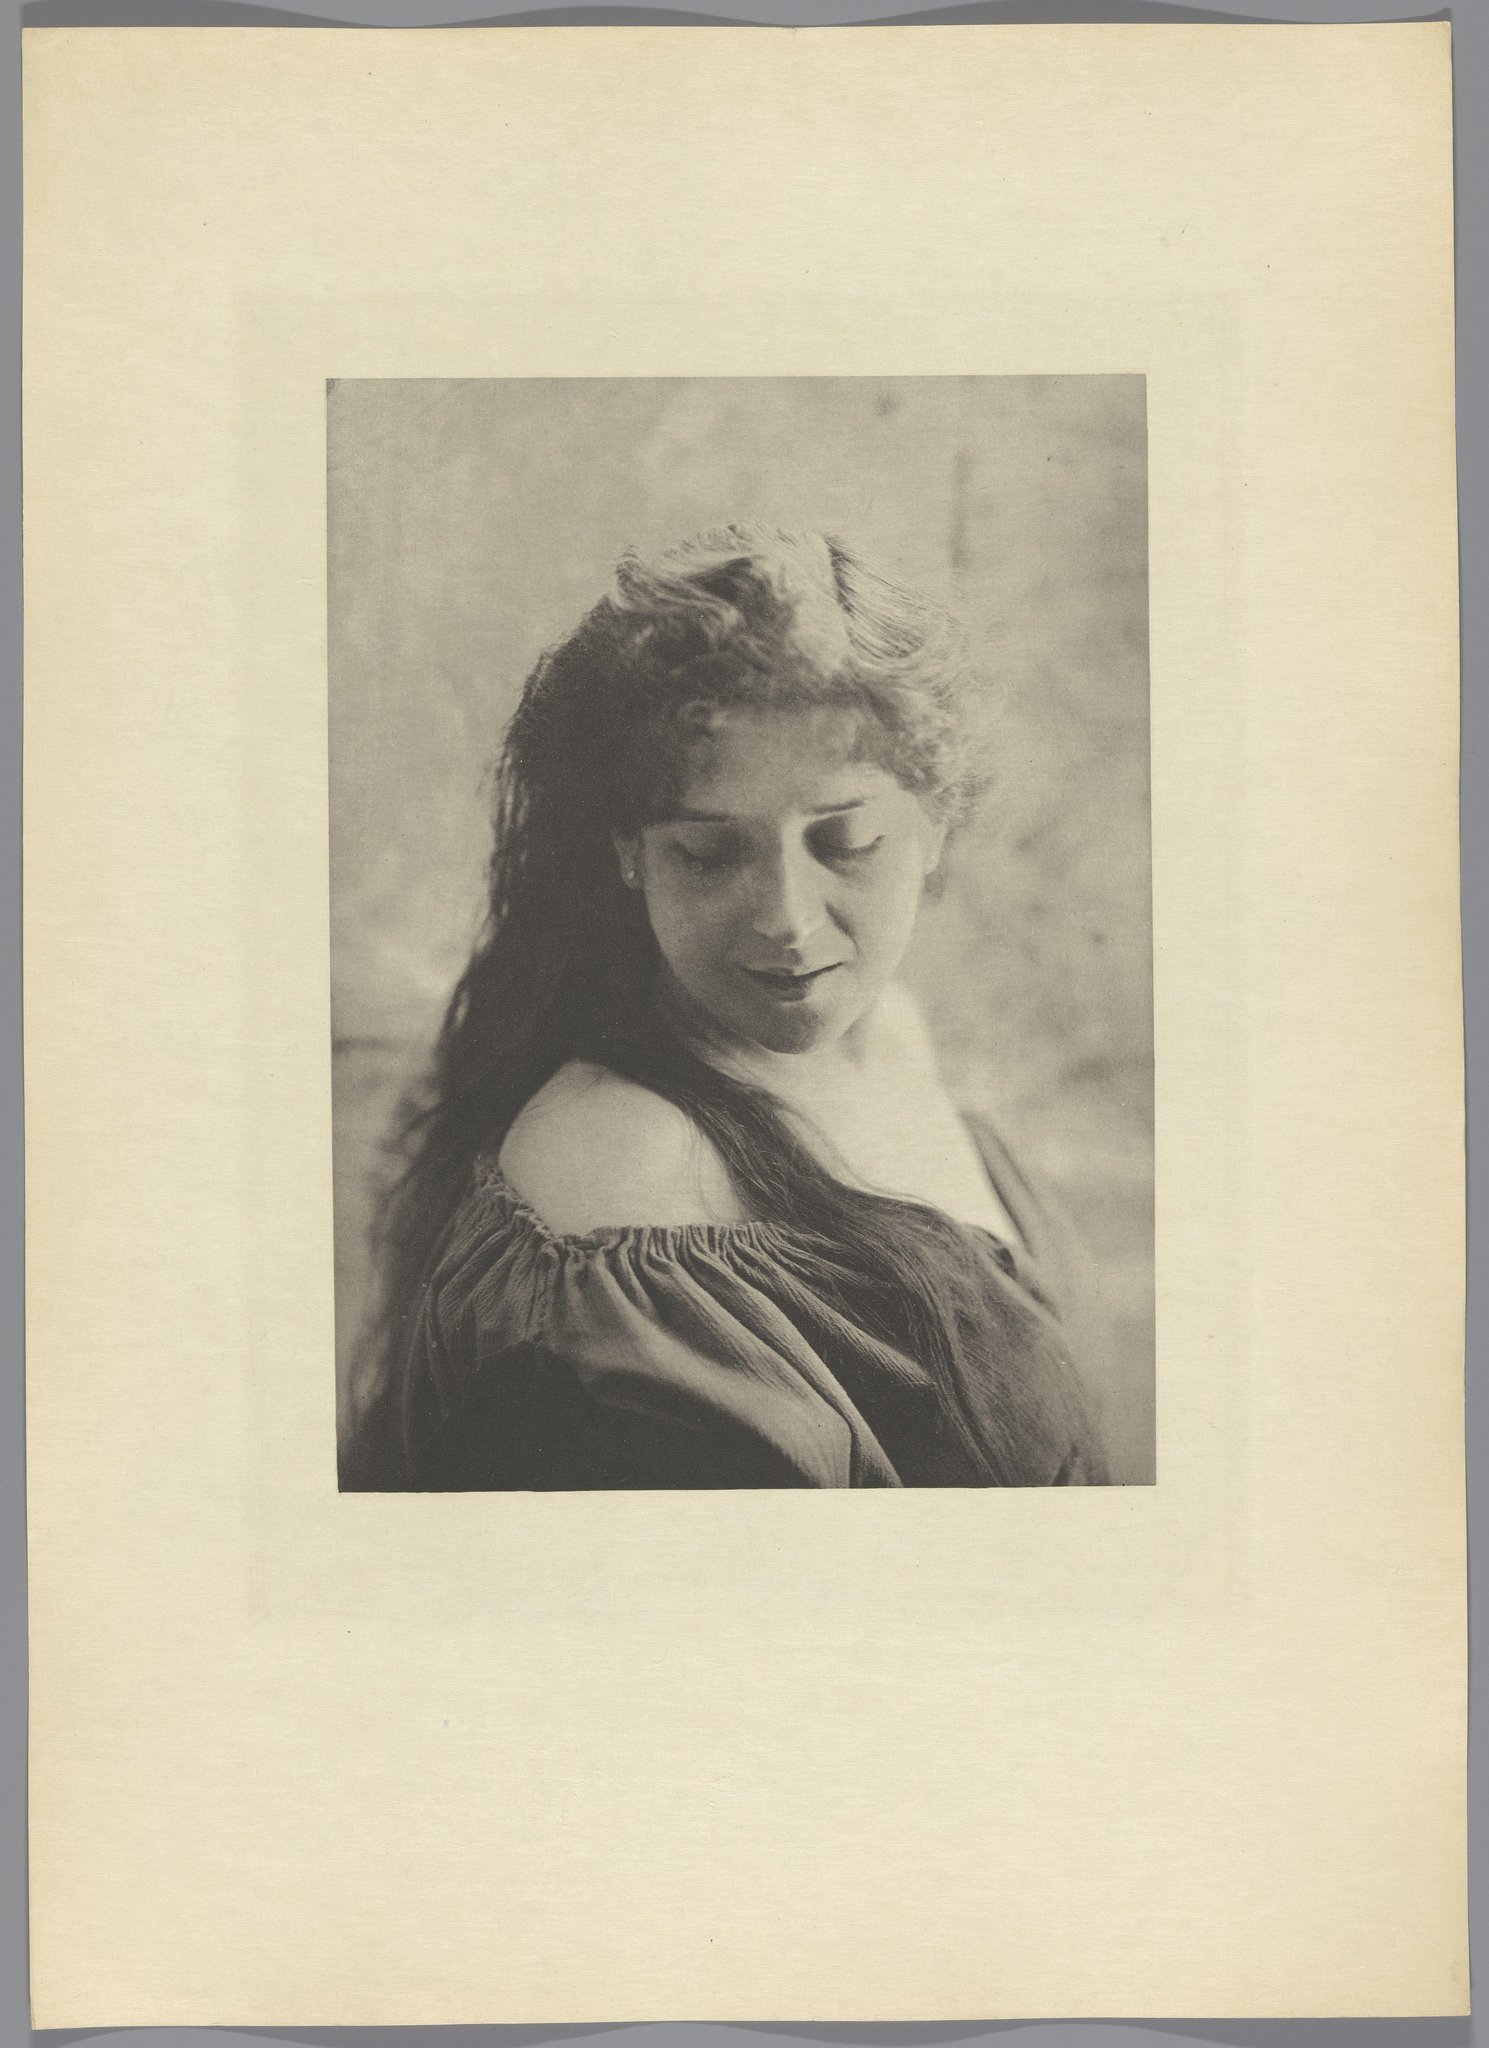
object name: photomechanical print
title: Portret van een onbekende jonge vrouw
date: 1891-1896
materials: paper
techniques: photoaquatint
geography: paris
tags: adolescent, young woman, maiden, historical persons not known by name - bb - woman